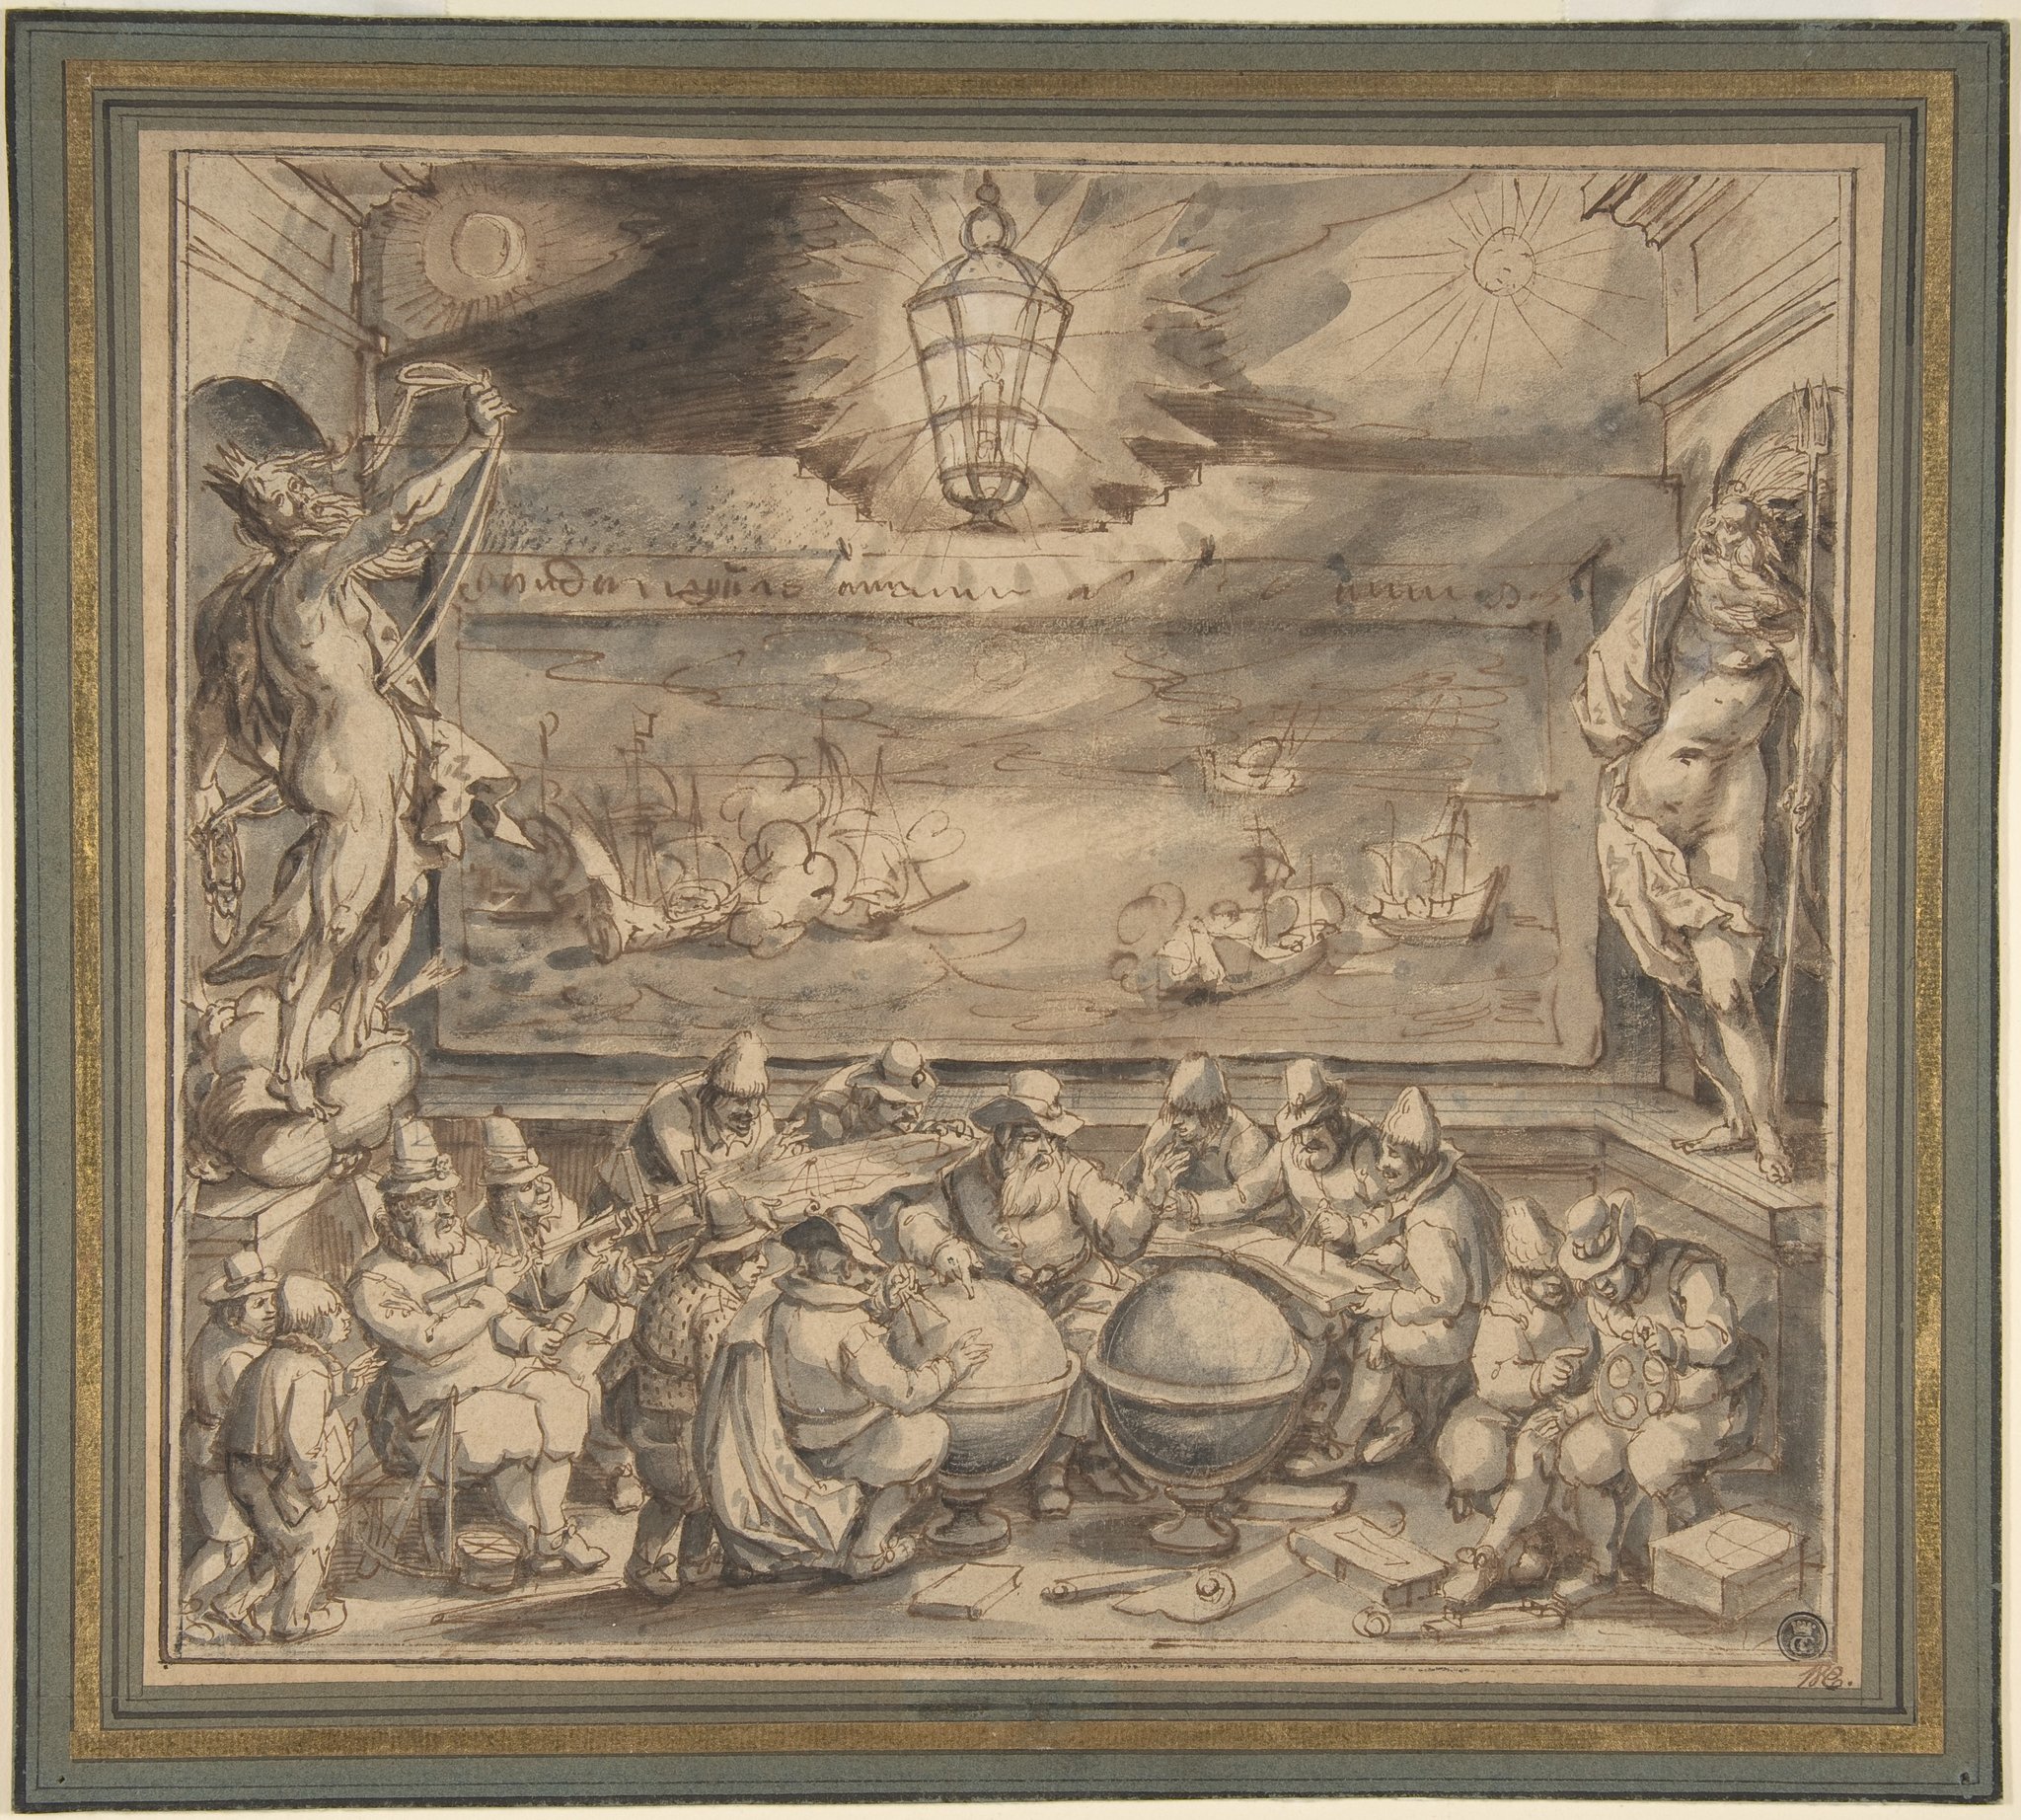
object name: drawing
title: Petrus Plancius Instructing Students in the Science of Navigation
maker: david vinckboons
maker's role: artist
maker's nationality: netherlandish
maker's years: 1576-1629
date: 1601-1633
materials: ink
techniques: wash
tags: men,astronomy,astronomers,ships,globes